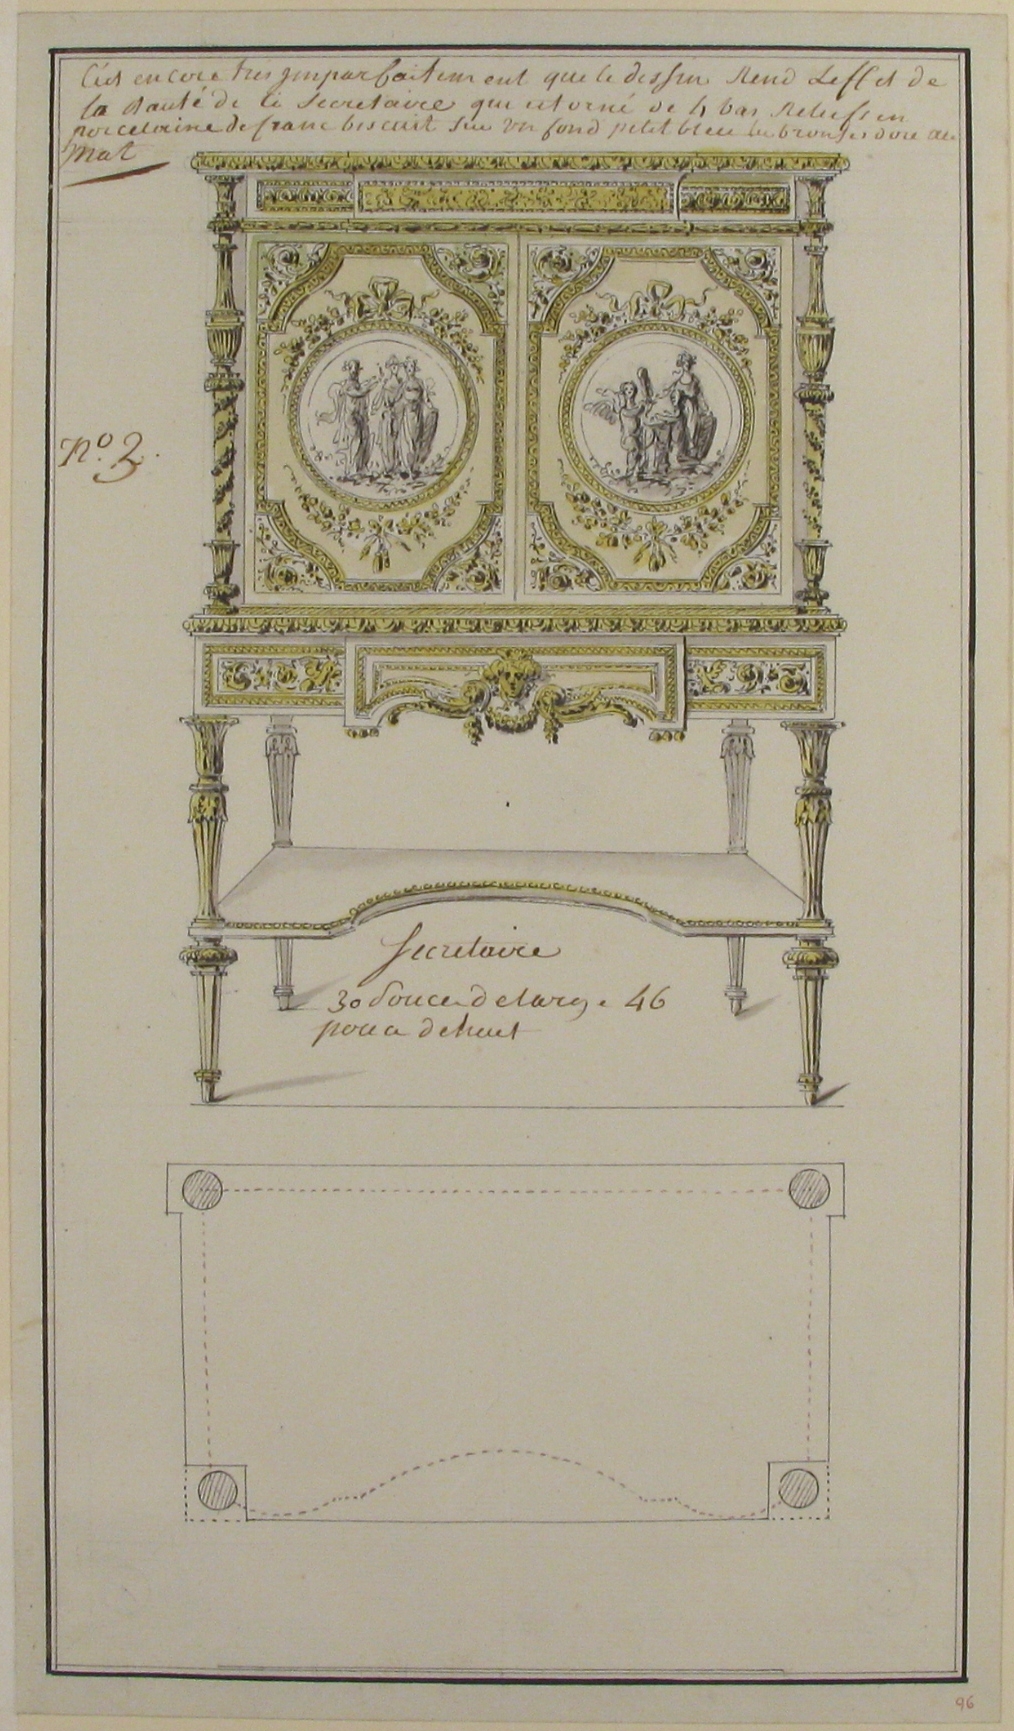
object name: drawing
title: Design for a Secretary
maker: anonymous, french, 18th century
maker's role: artist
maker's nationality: french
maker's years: 1700-1800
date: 1770-1785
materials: ink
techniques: brush, pen, wash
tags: furniture